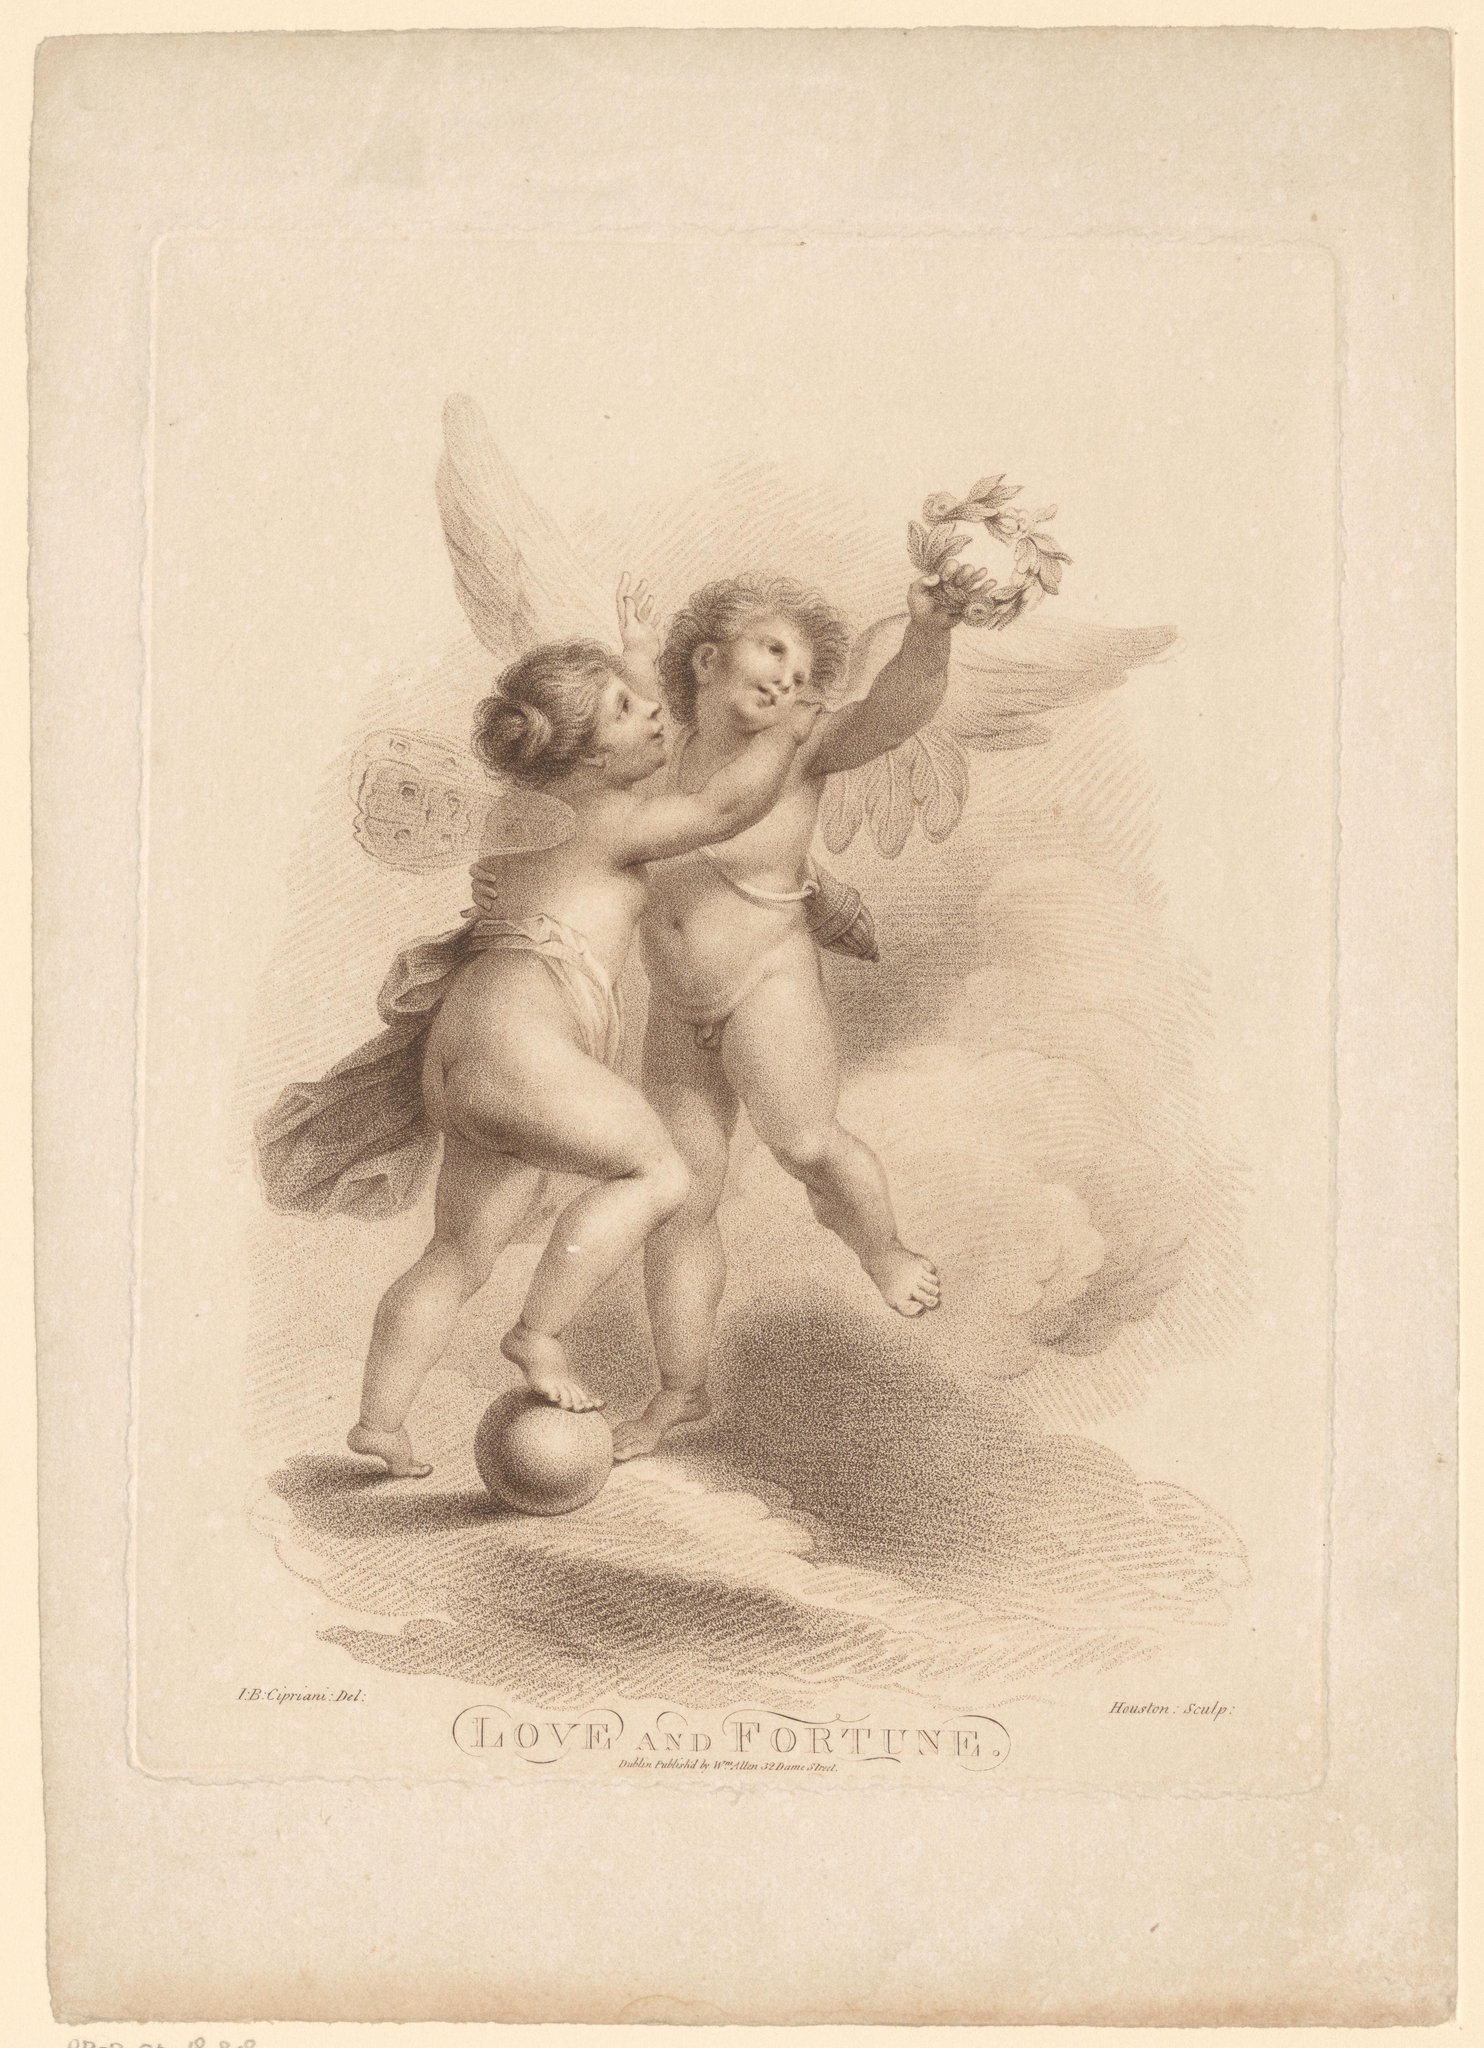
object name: print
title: Love and Fortune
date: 1791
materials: paper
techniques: printmaking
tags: success; 'evento buono' (ripa), love personified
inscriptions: collector's mark: Lugt 2228